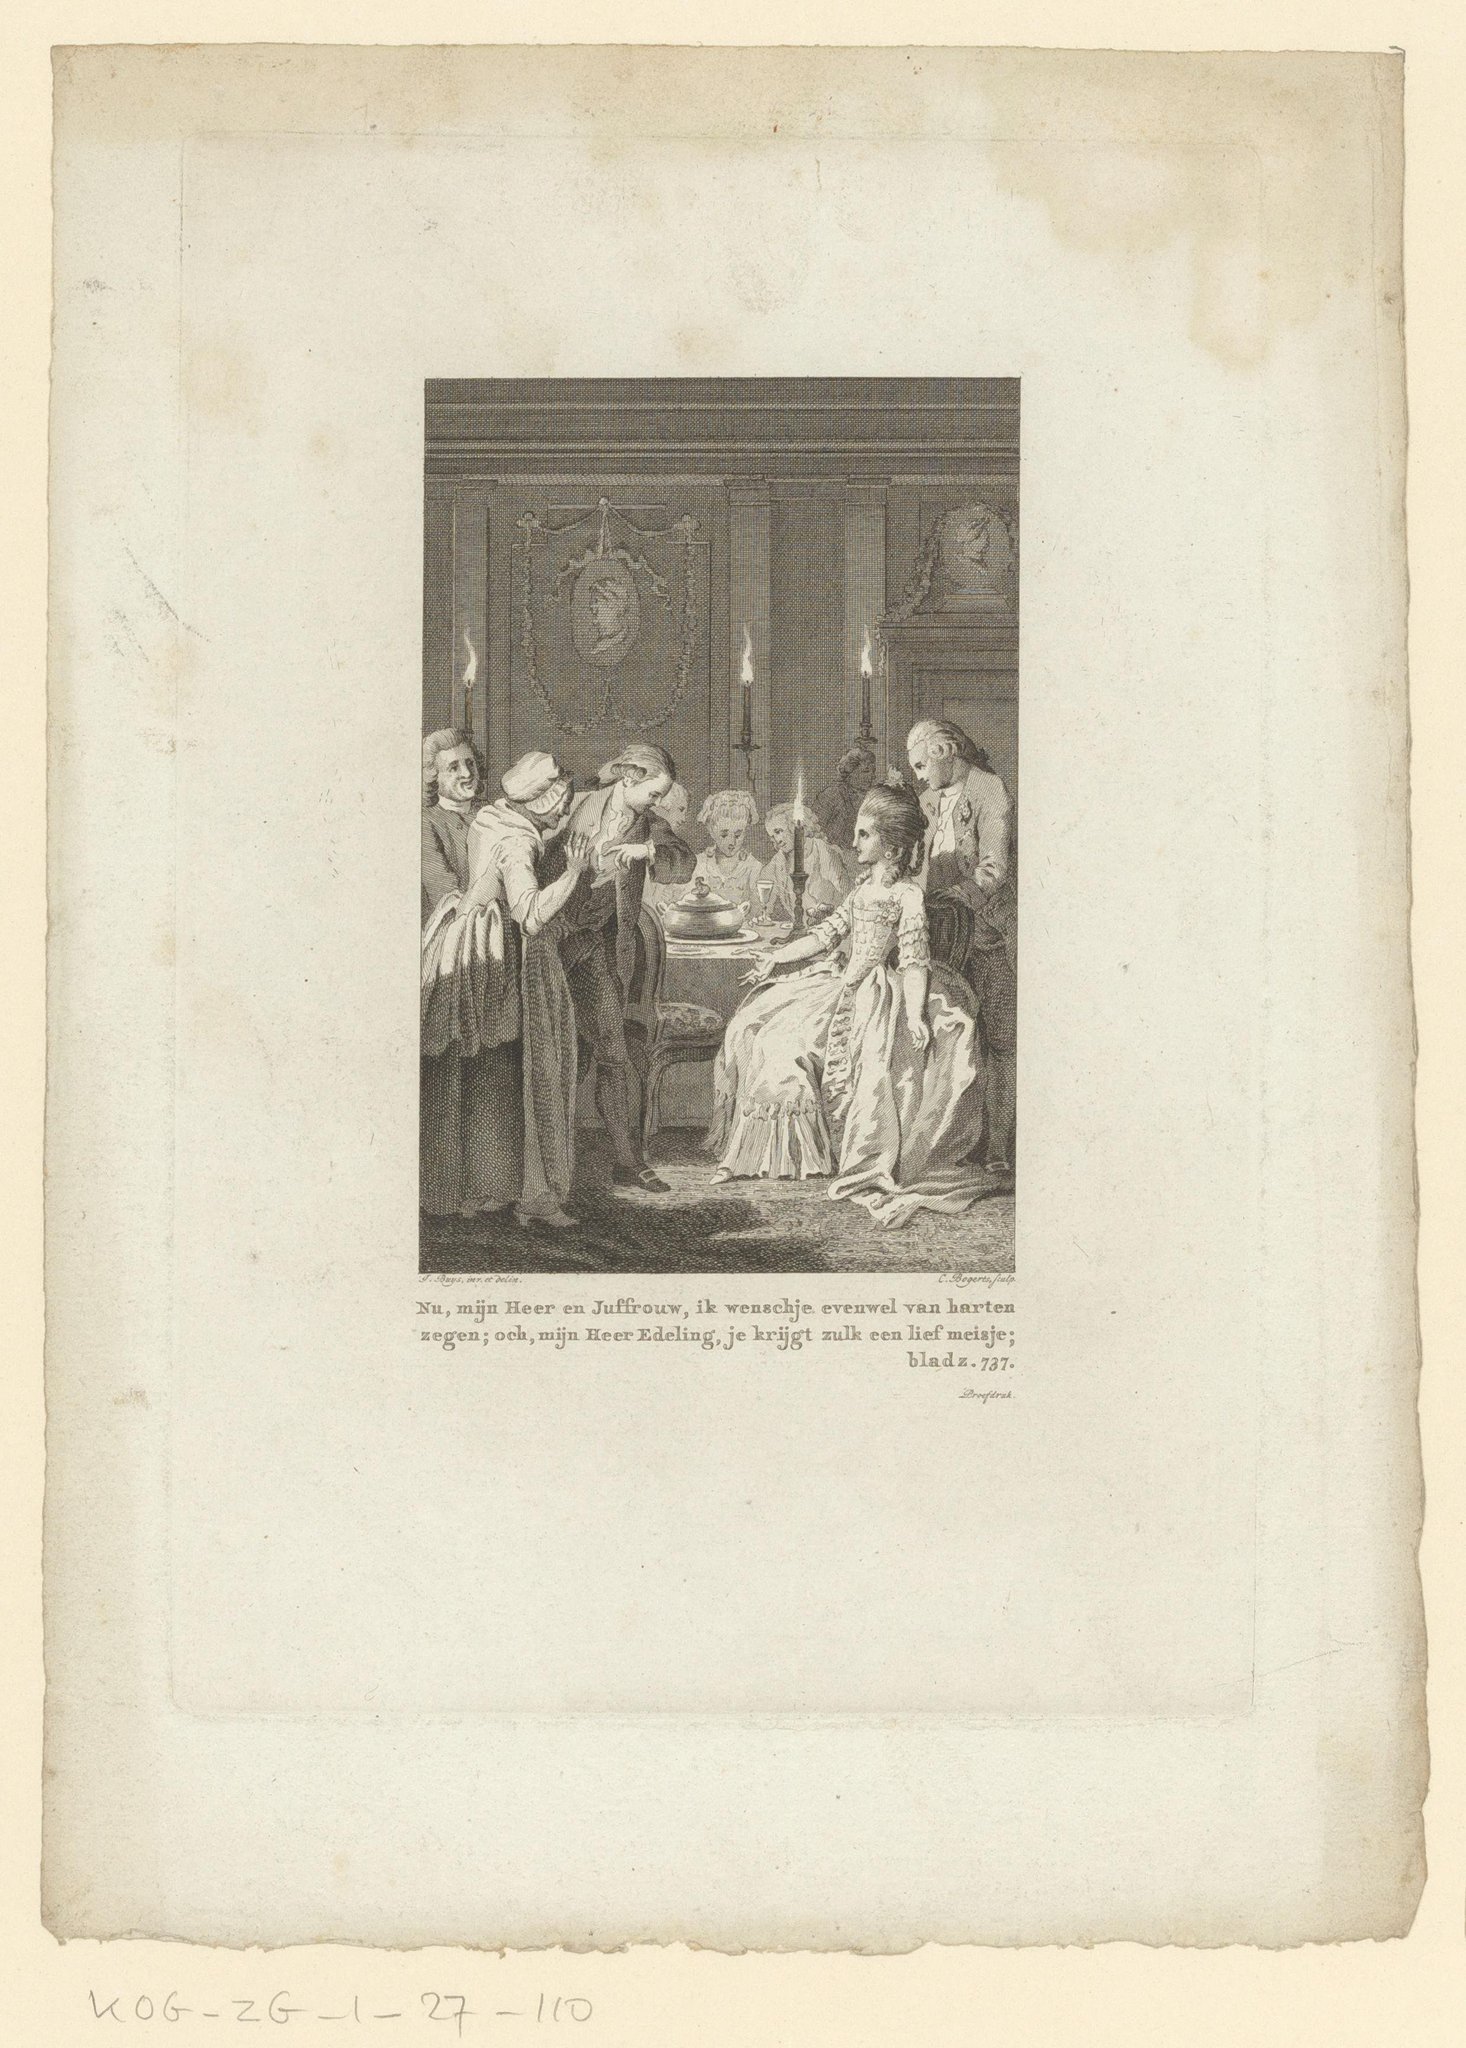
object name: print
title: Illustratie voor 'Historie van mejuffrouw Sara Burgerhart', 1782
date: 1782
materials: paper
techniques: engraving, etching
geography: netherlands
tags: candle, communal rooms, betrothal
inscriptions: collector's mark: Lugt 1641, collector's mark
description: Gebruikt als illustratie in: E. Bekker en A. Deken, Historie van mejuffrouw Sara Burgerhart, Den Haag: Isaac van Cleef, 1782.